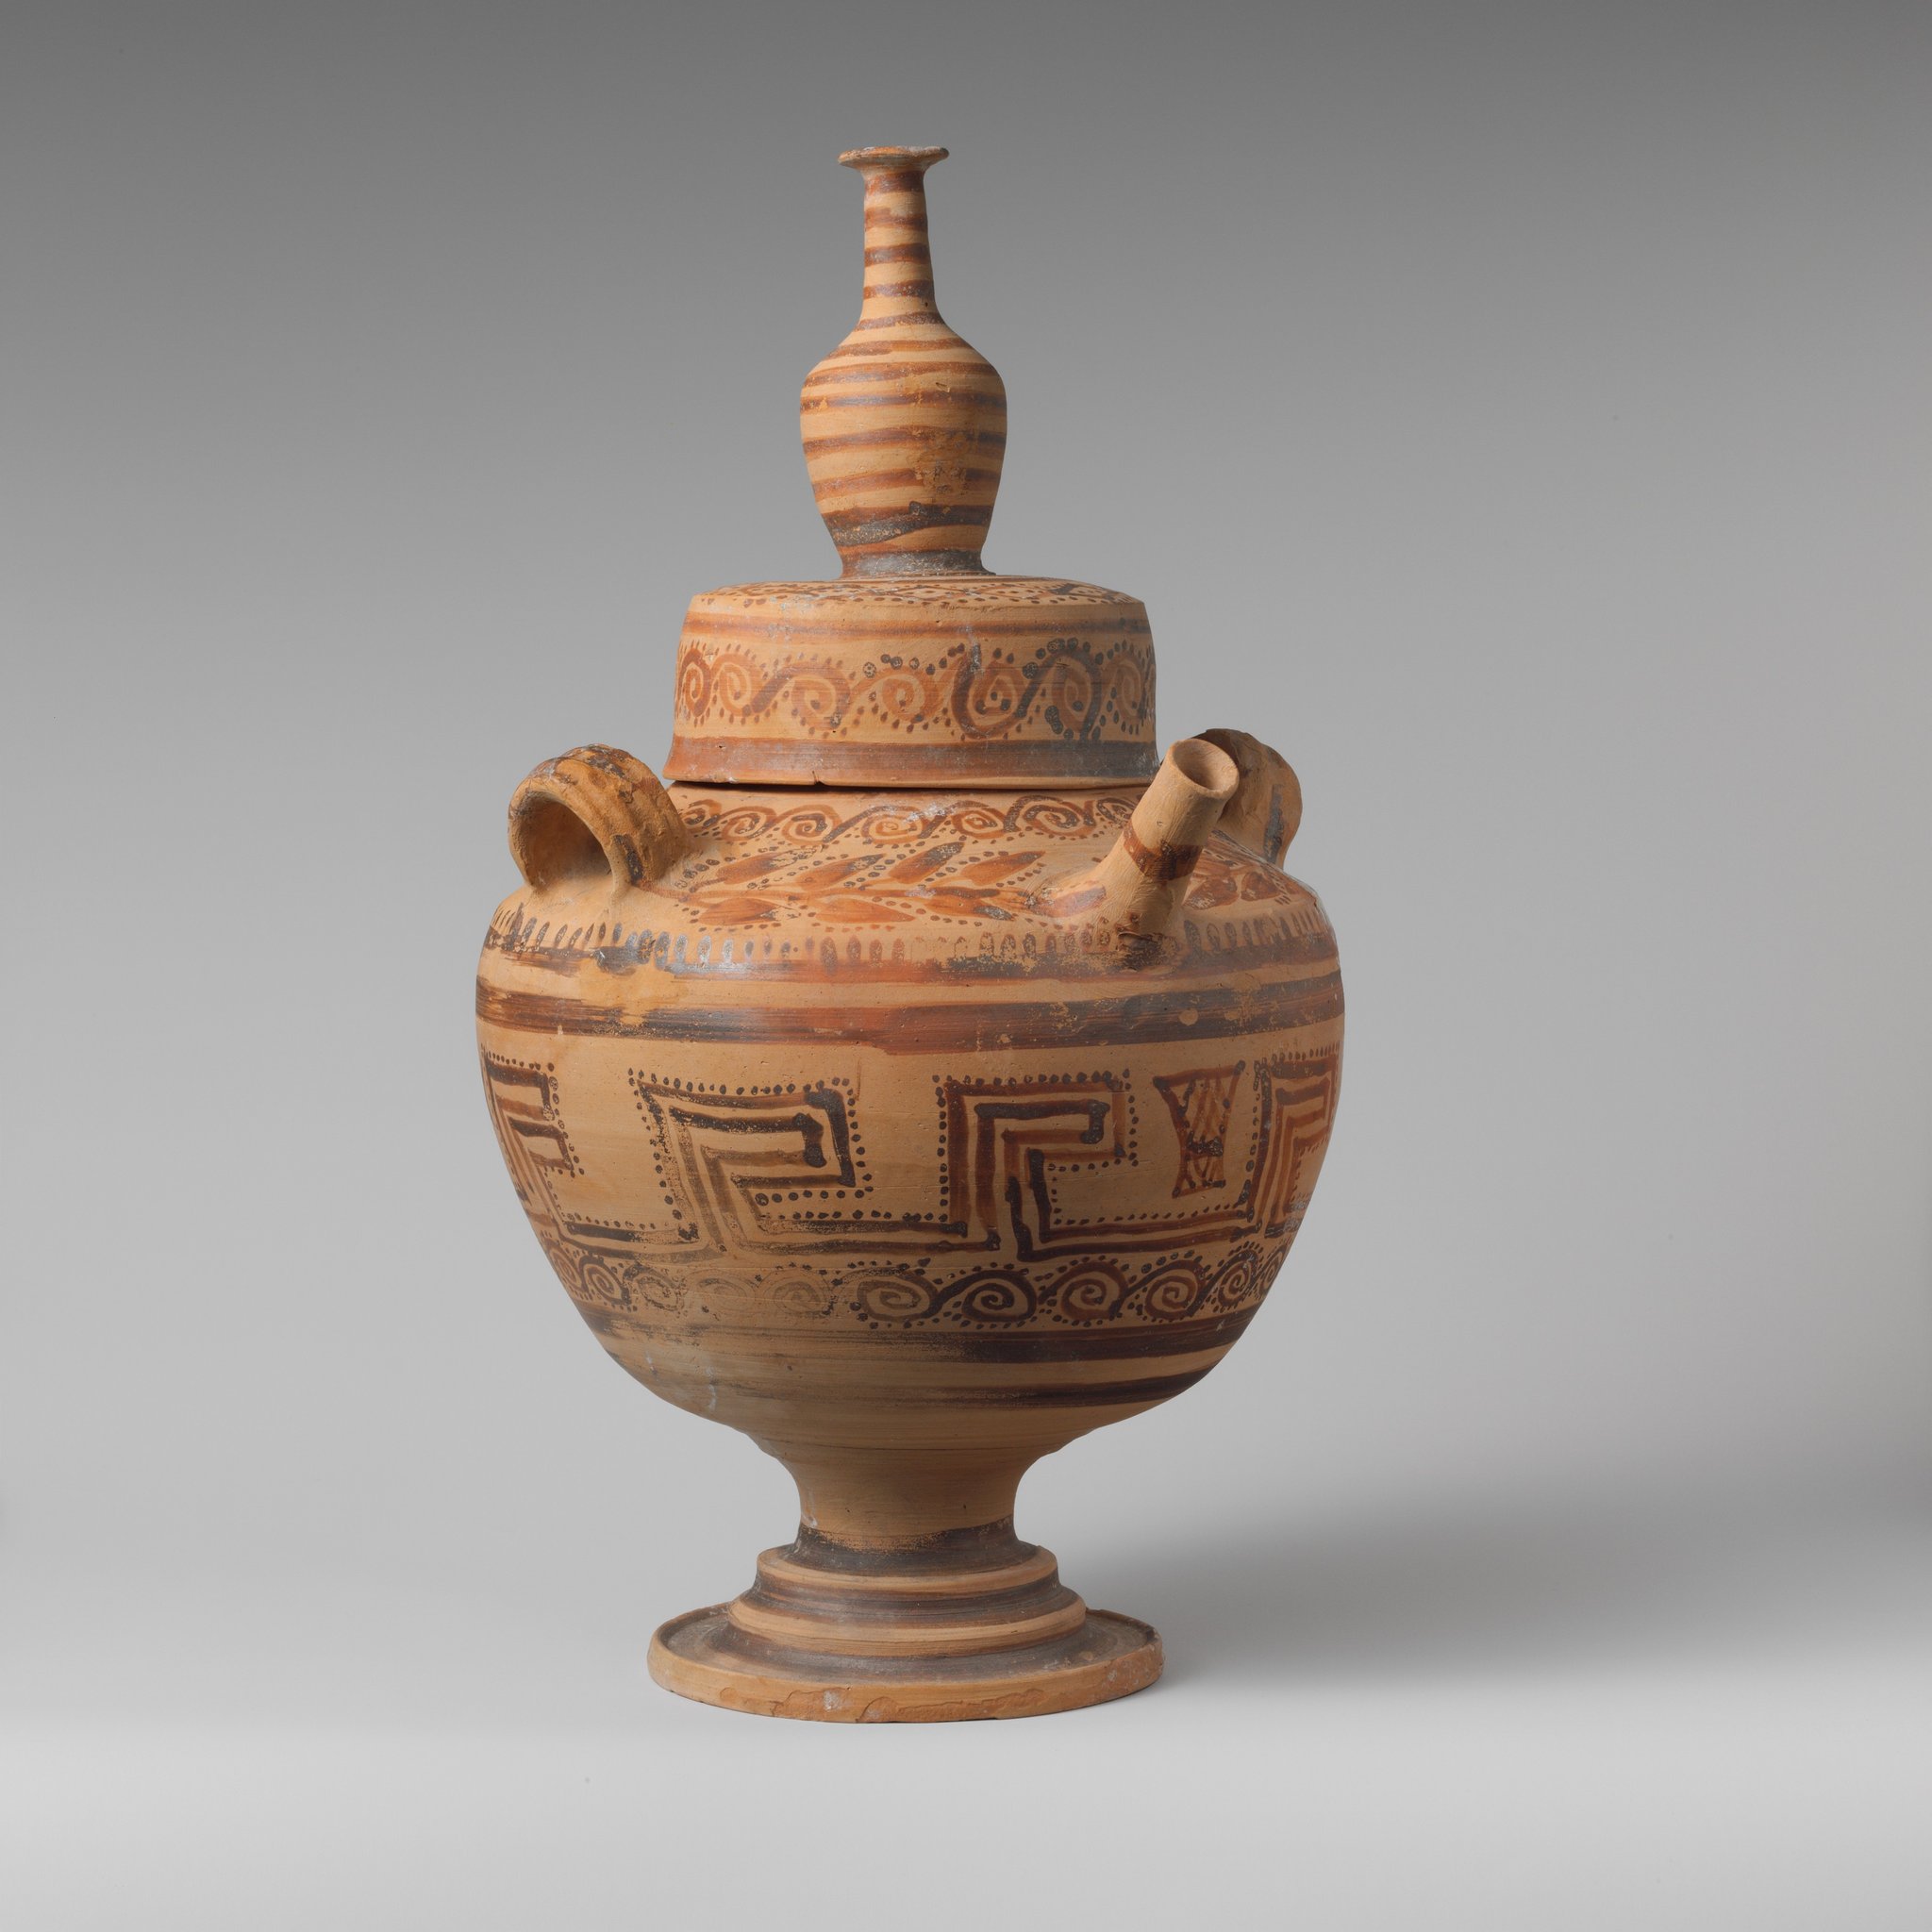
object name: jar with lid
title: Terracotta spouted jar with lid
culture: cypriot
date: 310-30 BCE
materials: terracotta